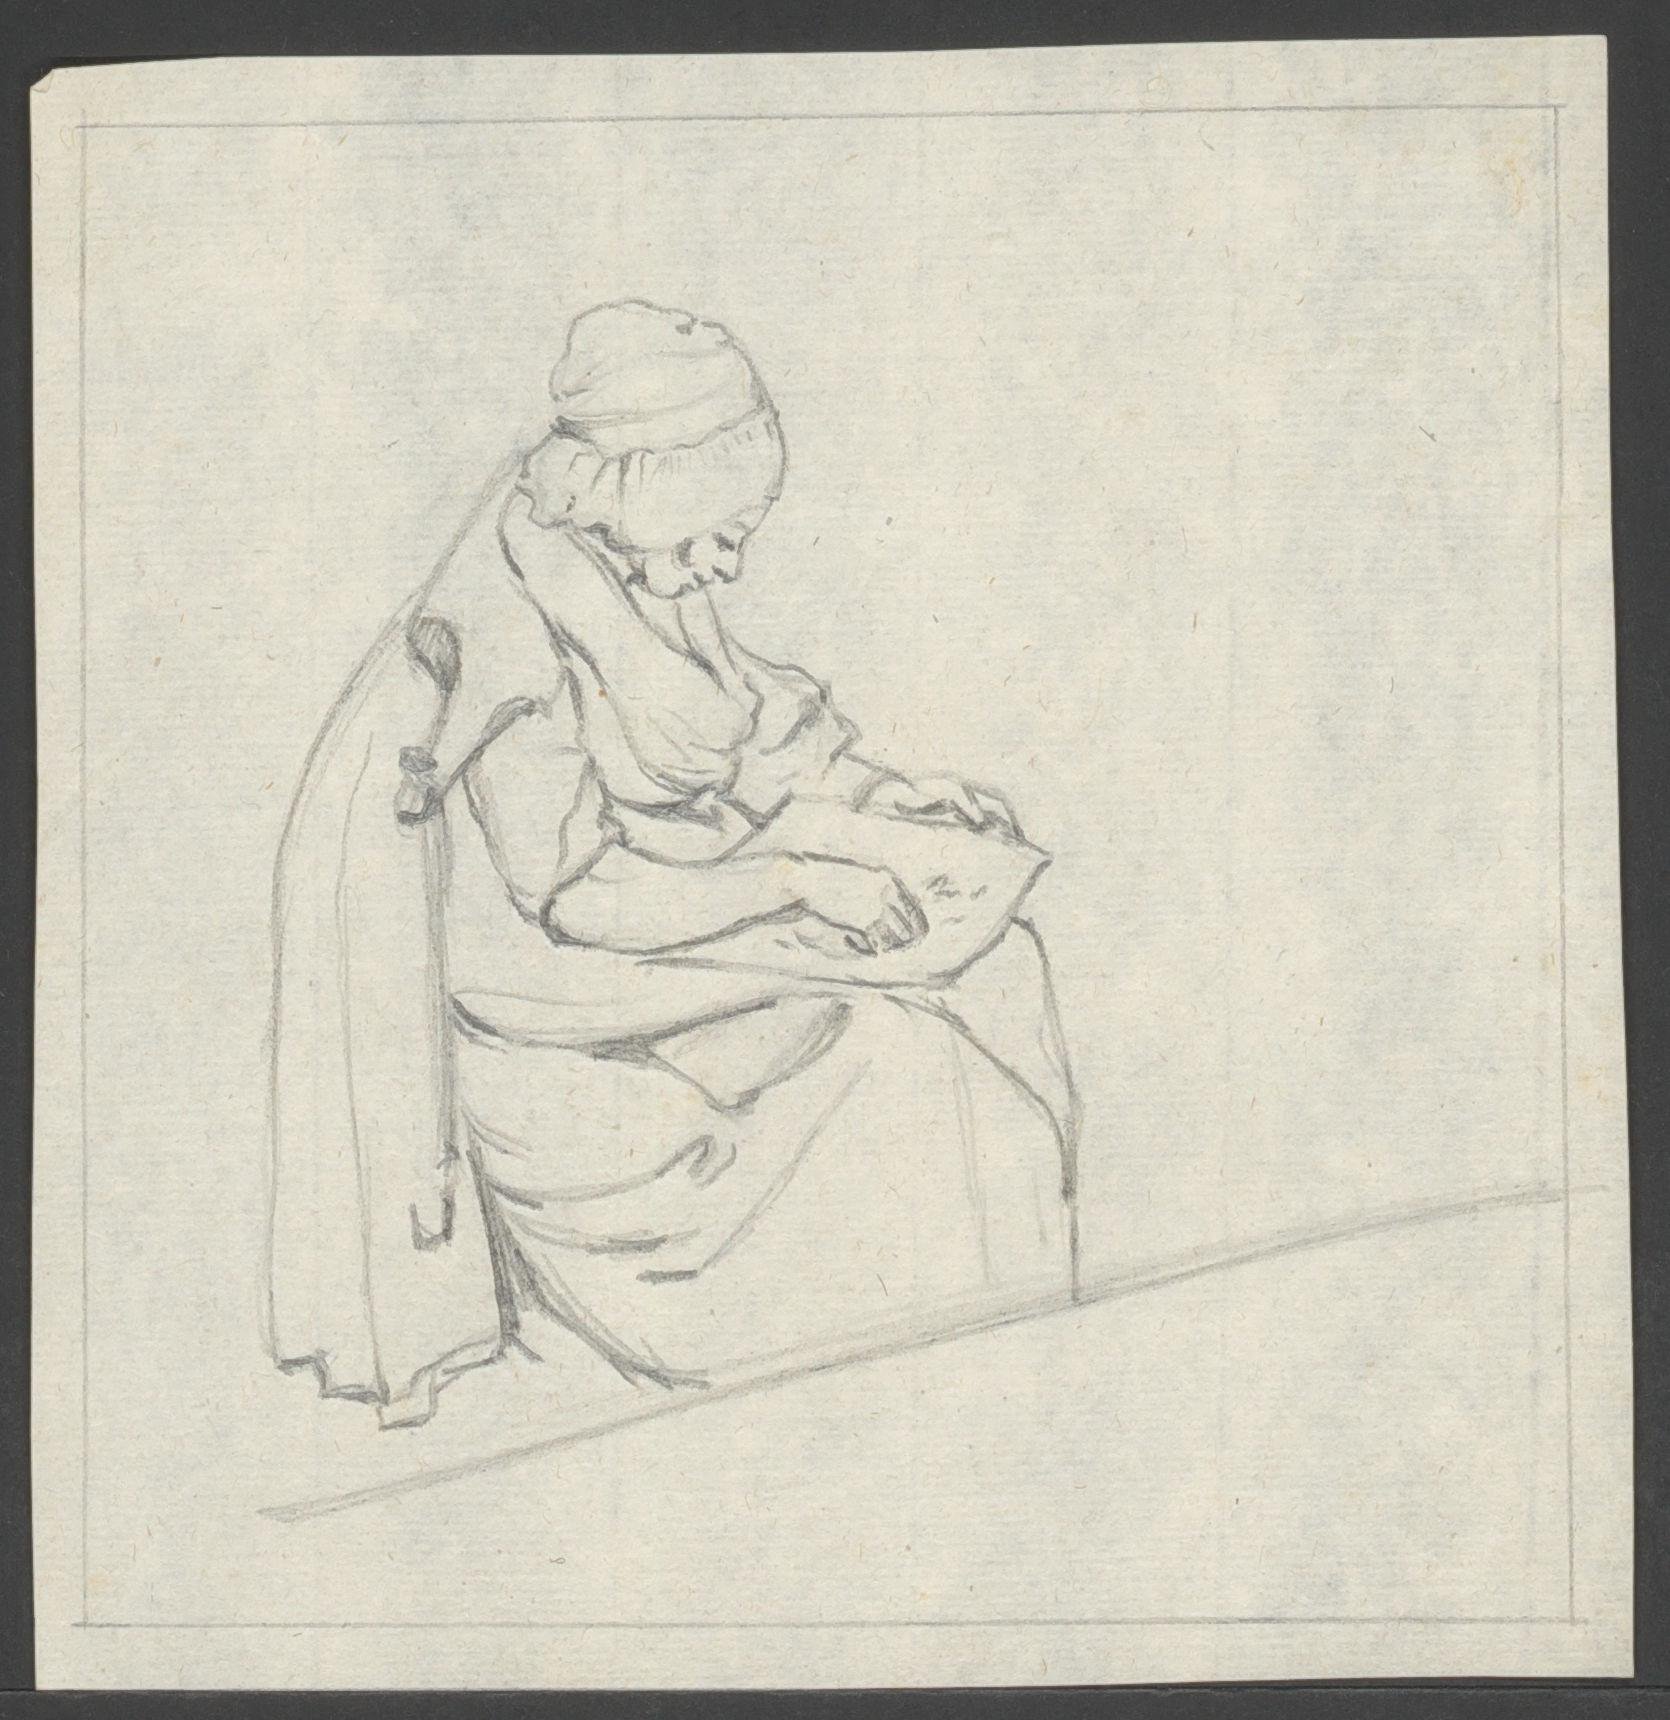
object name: drawing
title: Lezende vrouw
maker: Anonymous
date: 1800-1899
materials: paper, pencil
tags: reading, sitting figure - aa - female human figure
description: Onderwerpsrubrieken binnen de Atlas Zeden en Gewoonten: Schoone kunsten, Schilderkunst, Tekeningen.